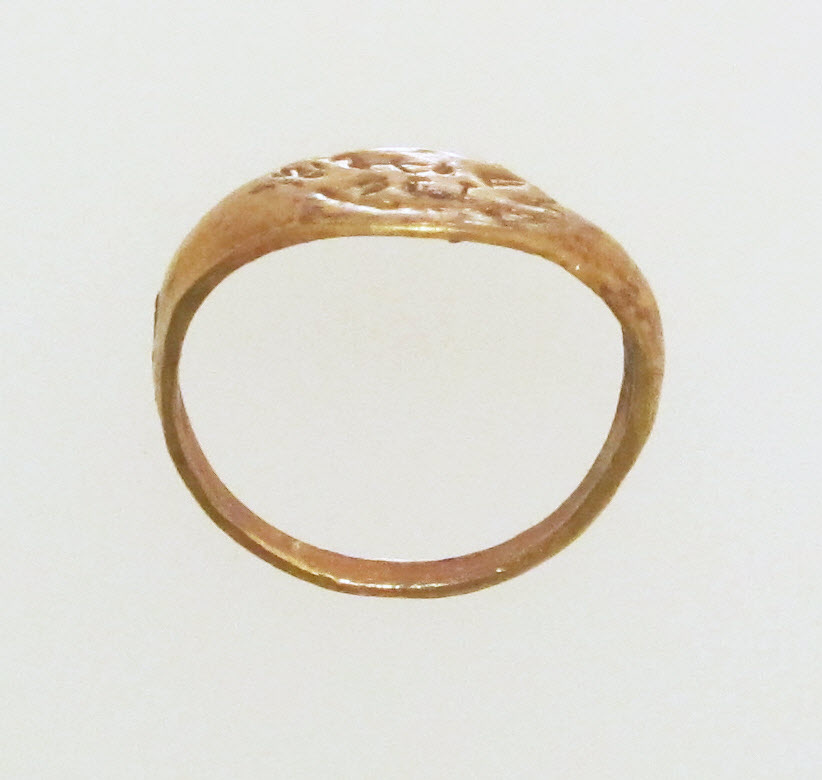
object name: ring, motto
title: Gold ring with inscribed bezel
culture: roman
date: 100 BCE-300 CE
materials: gold